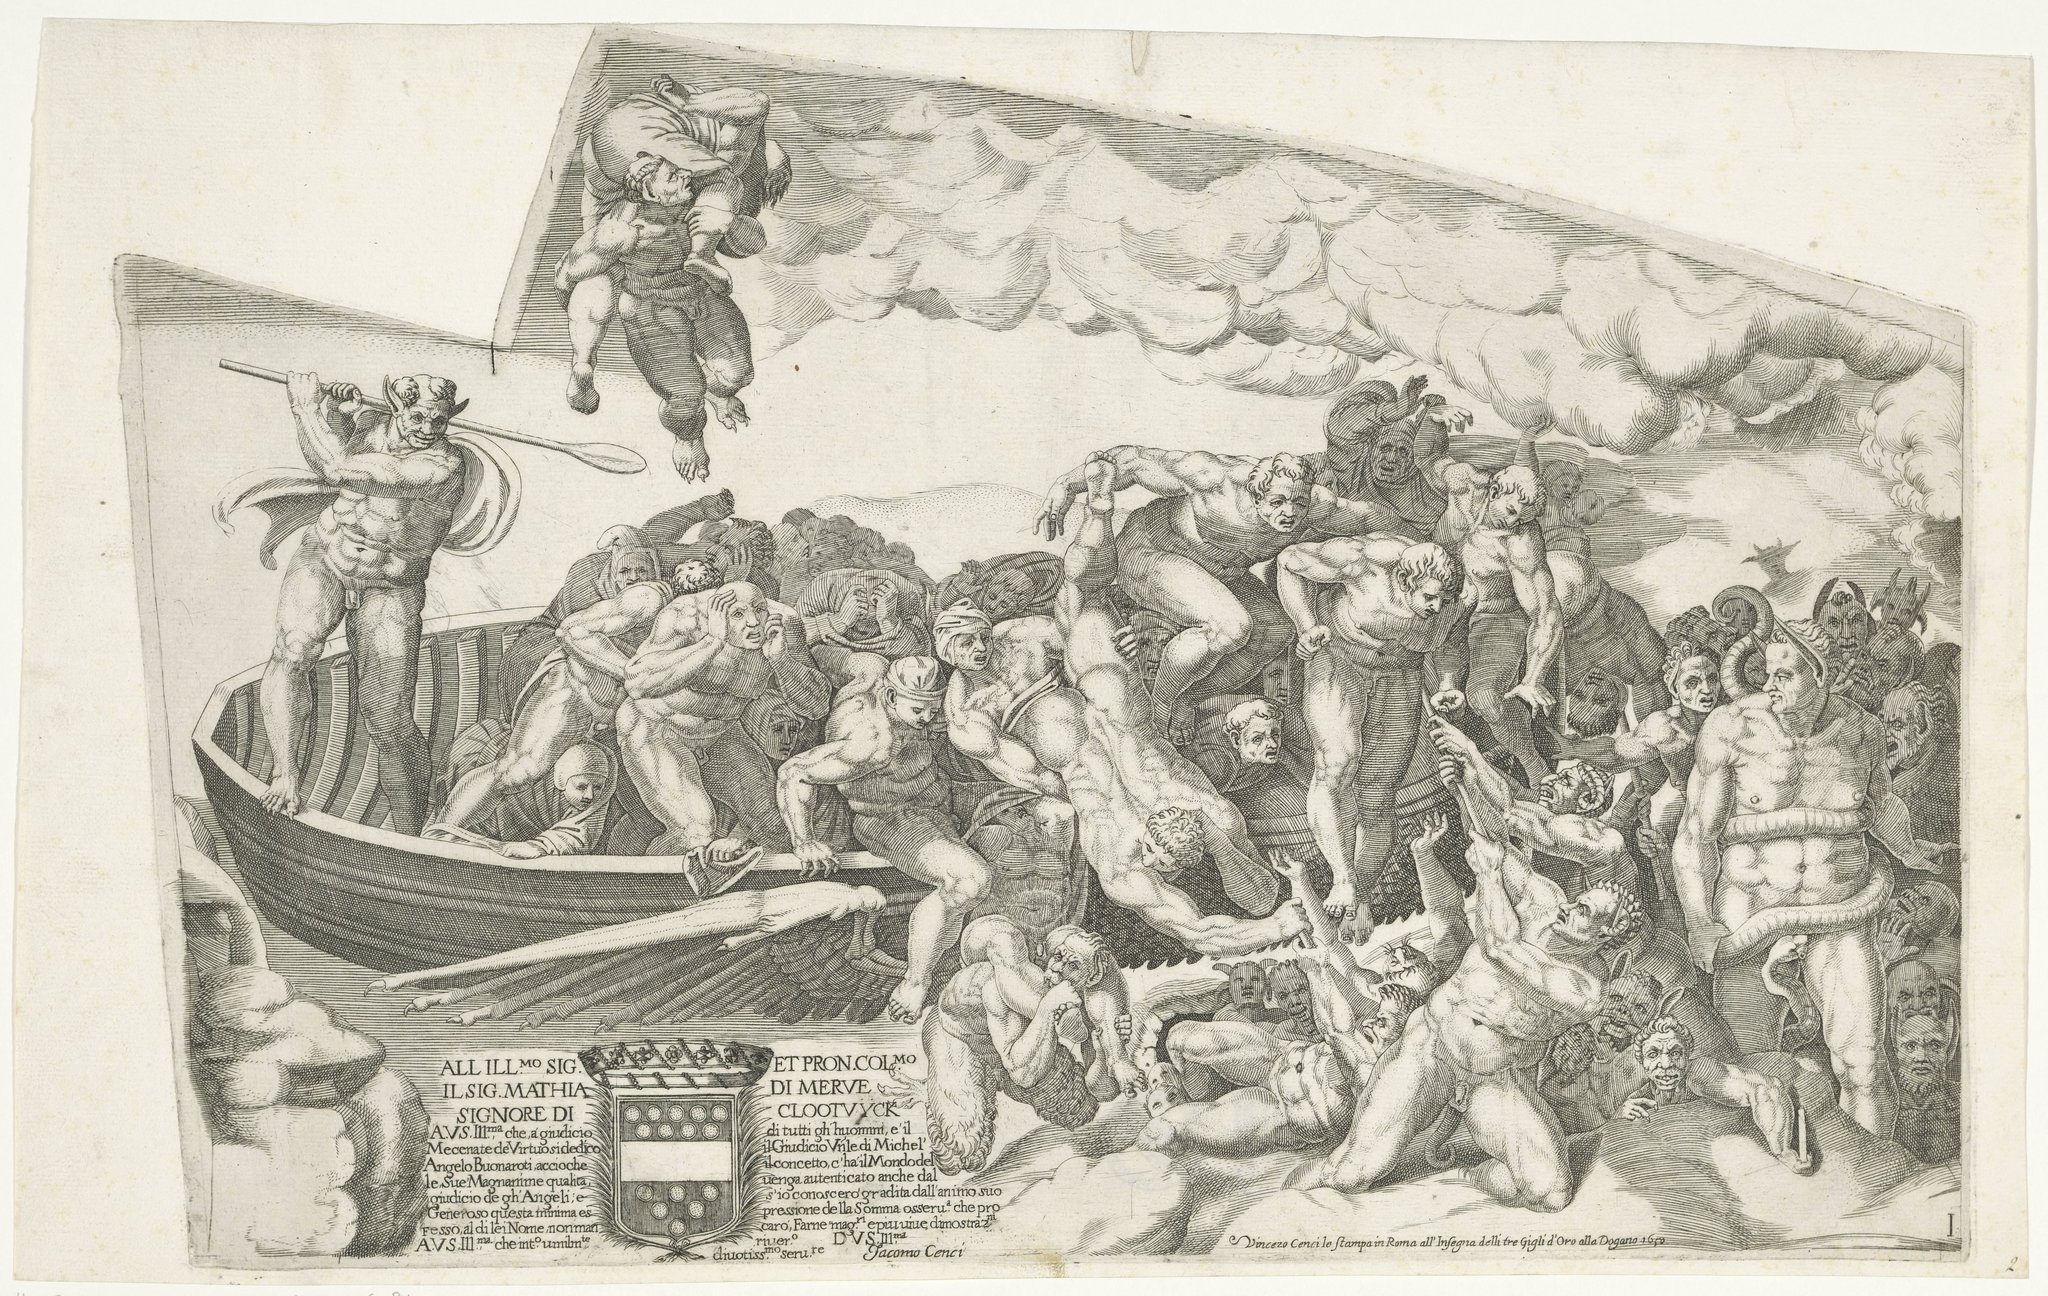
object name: print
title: Het laatste oordeel, blad I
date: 1582-1650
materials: paper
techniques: engraving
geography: vatican city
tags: last judgement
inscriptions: number: ‘2’, collector's mark: ‘Hinloopen’, collector's mark: Lugt 11, collector's mark: Lugt 10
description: Prent maakt deel uit van een groep van tien prenten die samen één grote voorstelling vormen naar het fresco met het Laatste Oordeel door Michelangelo in de Sixtijnse Kapel in het Vaticaan.